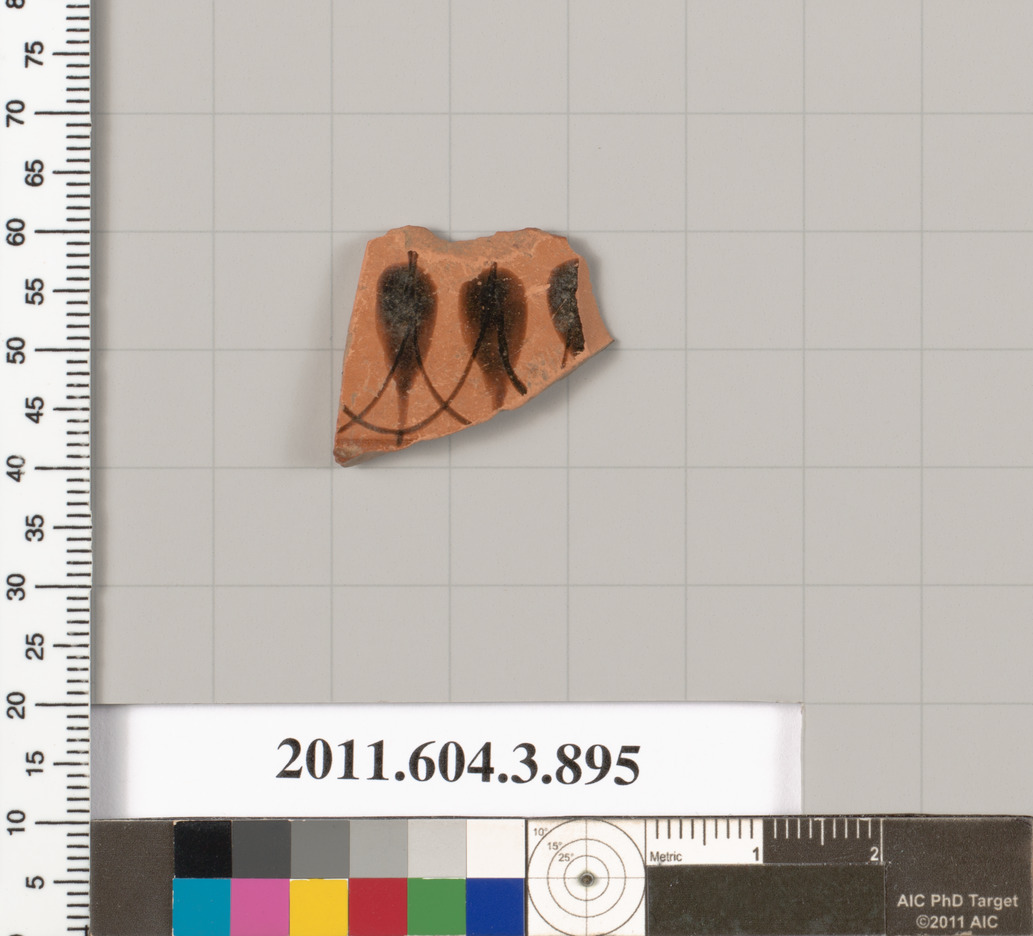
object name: lekythos fragment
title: Terracotta fragment of a lekythos (oil flask)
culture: greek, attic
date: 534-501 BCE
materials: terracotta